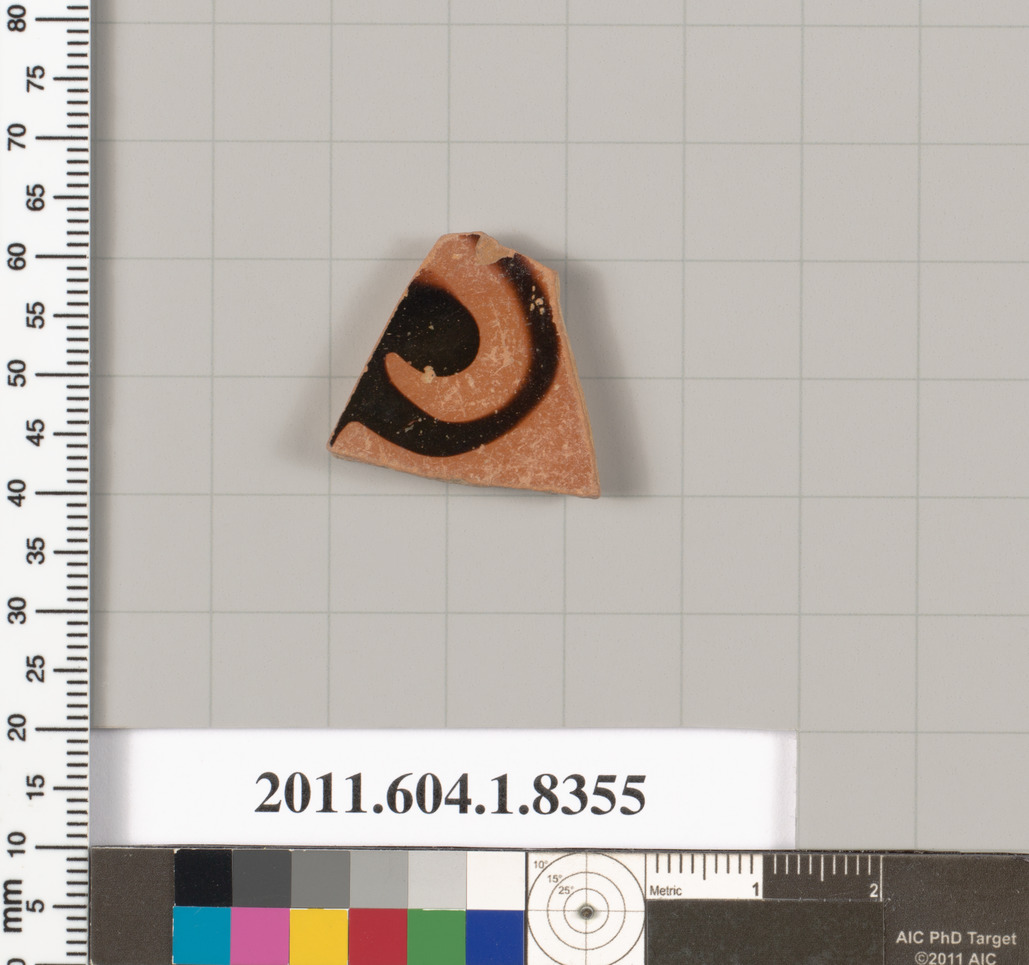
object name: kylix fragment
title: Terracotta fragment of a kylix (drinking cup)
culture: greek, attic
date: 375-351 BCE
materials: terracotta